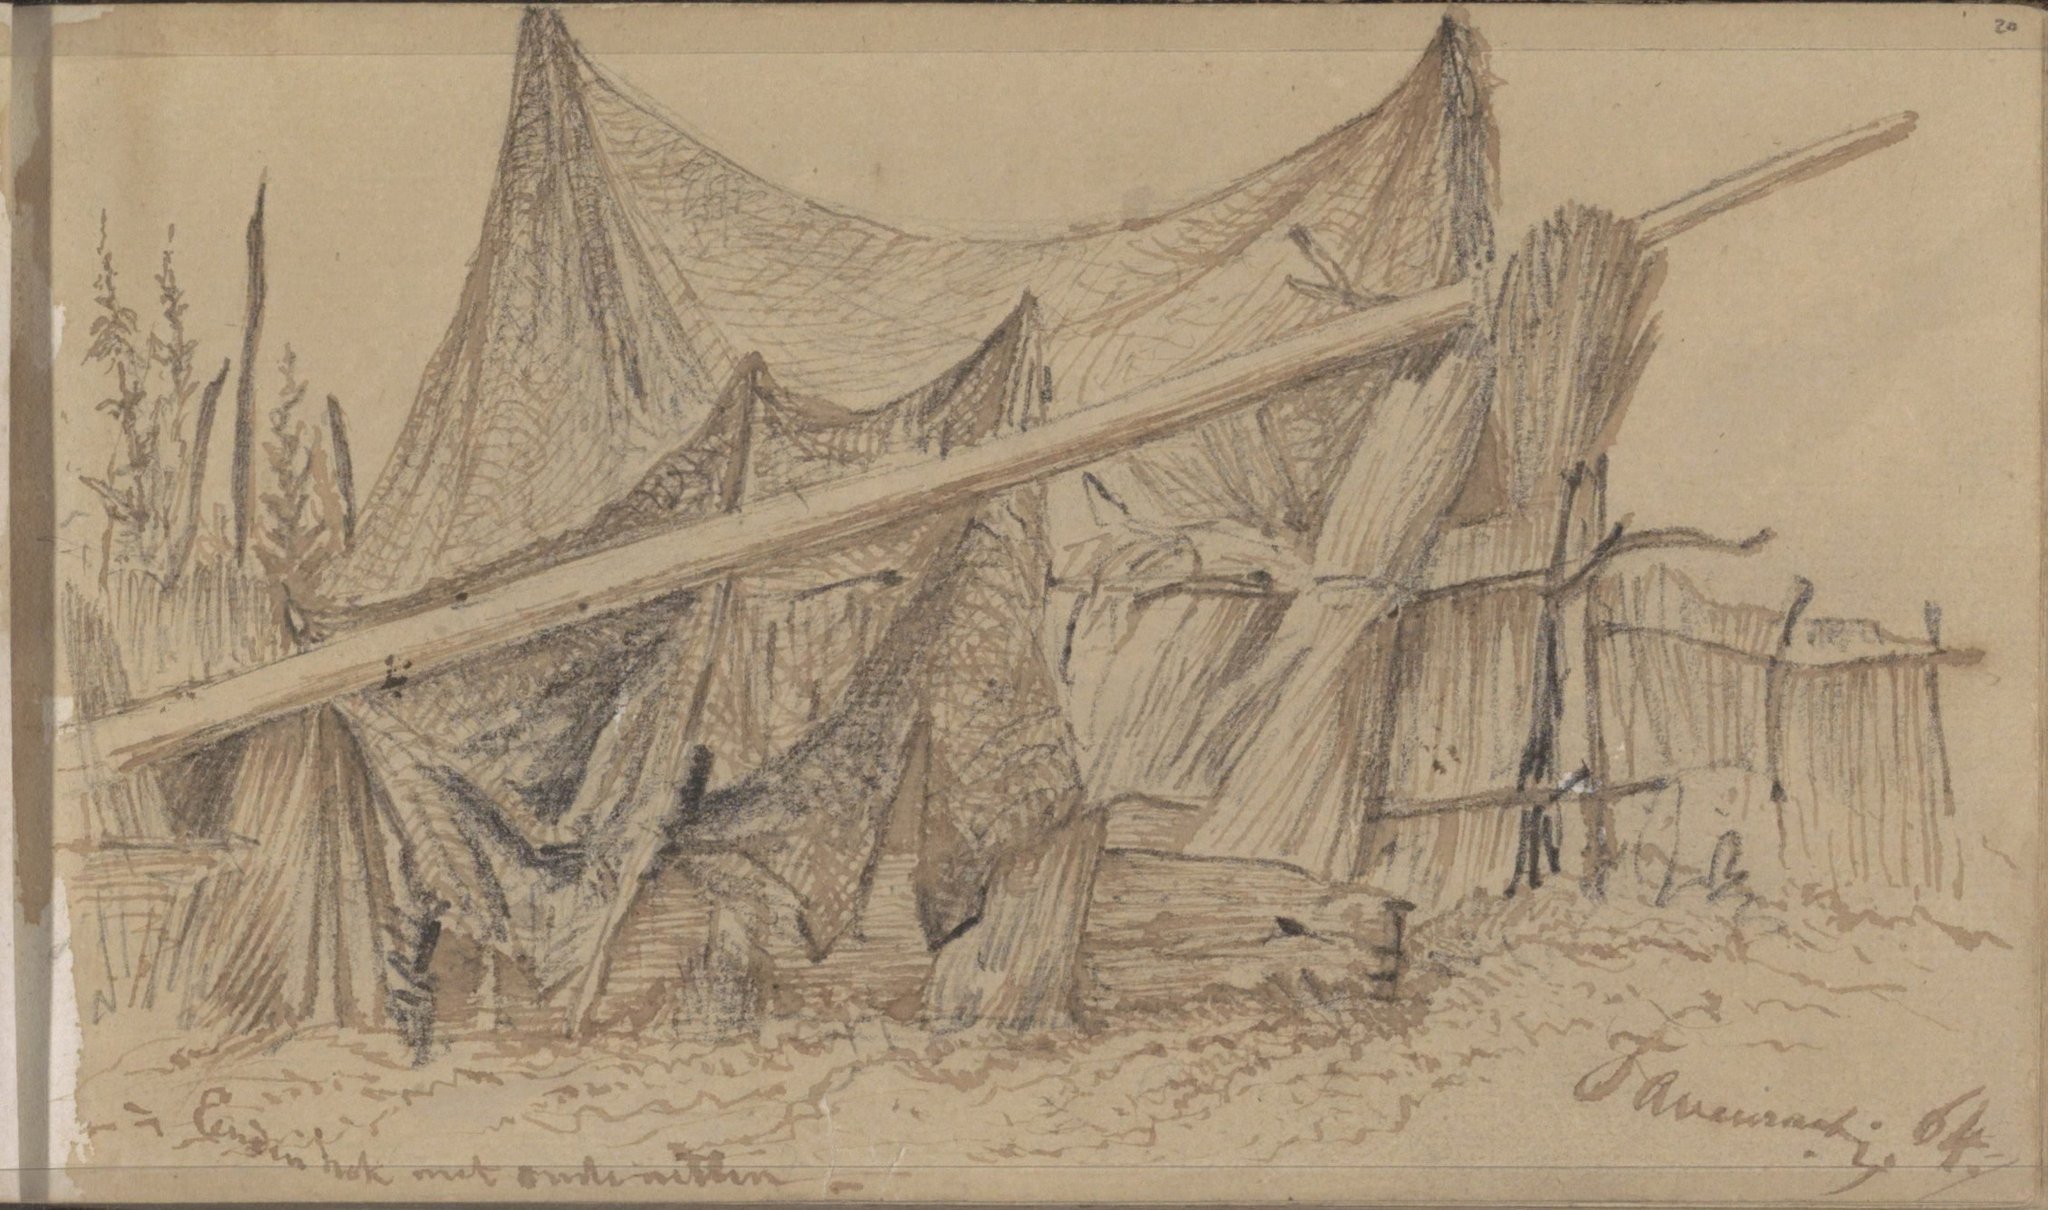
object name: sketchbook leaf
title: Eendenhut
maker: johannes tavenraat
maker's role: draughtsman, painter, print maker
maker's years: 1809-1881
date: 1864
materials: ink, paper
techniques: brush, pen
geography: capelle aan den ijssel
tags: hut, cabin, lodge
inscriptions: date and inscription: ‘Eendenhut met oude n[...]in 64’, signature: ‘Tavenraat’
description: Blad 20 recto uit een schetsboek met 98 bladen.